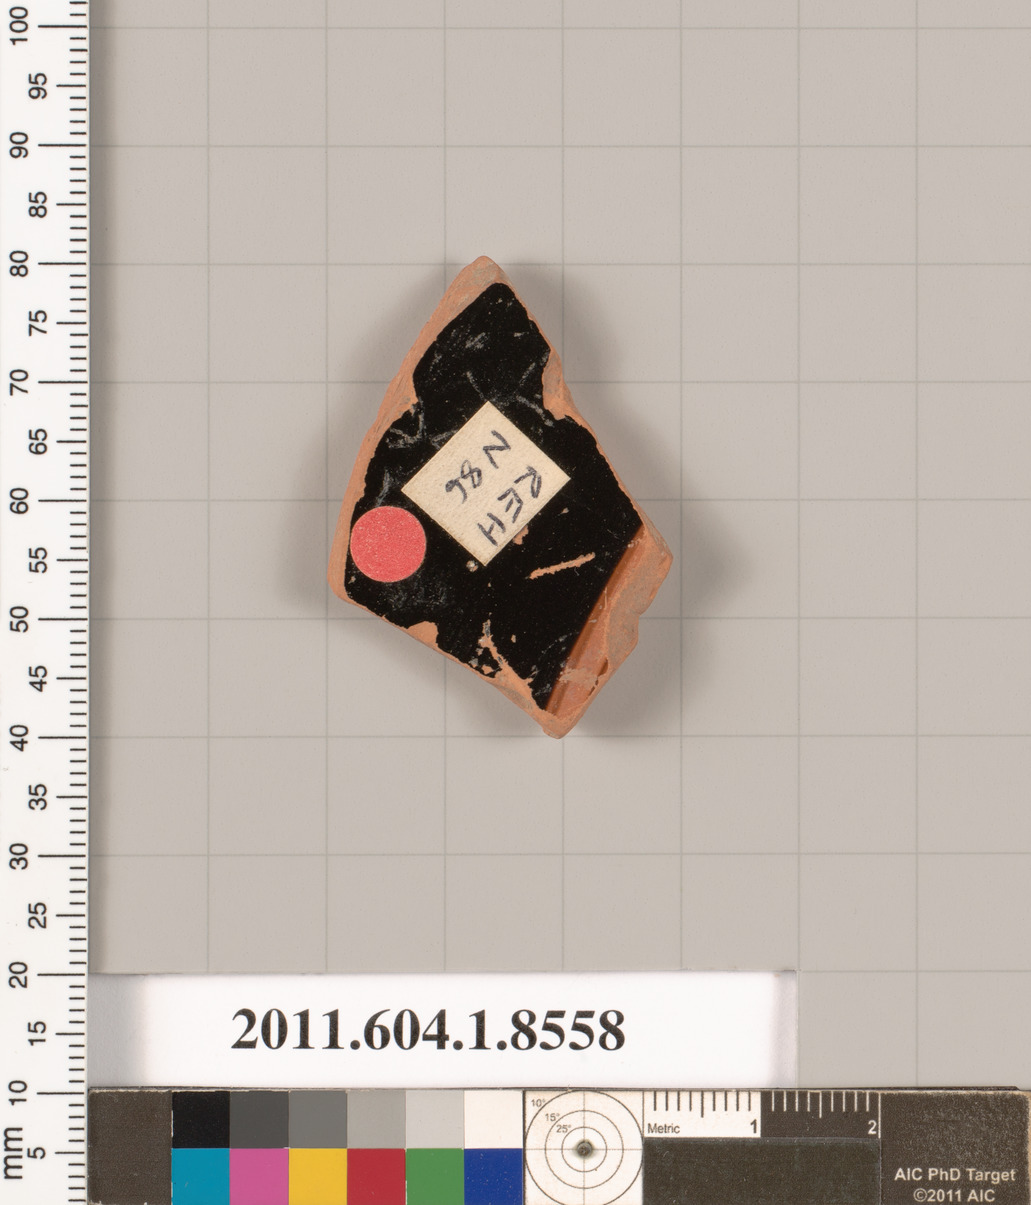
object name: kylix fragment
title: Terracotta fragment of a stemless kylix (drinking cup)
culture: greek, attic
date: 450-440 BCE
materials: terracotta